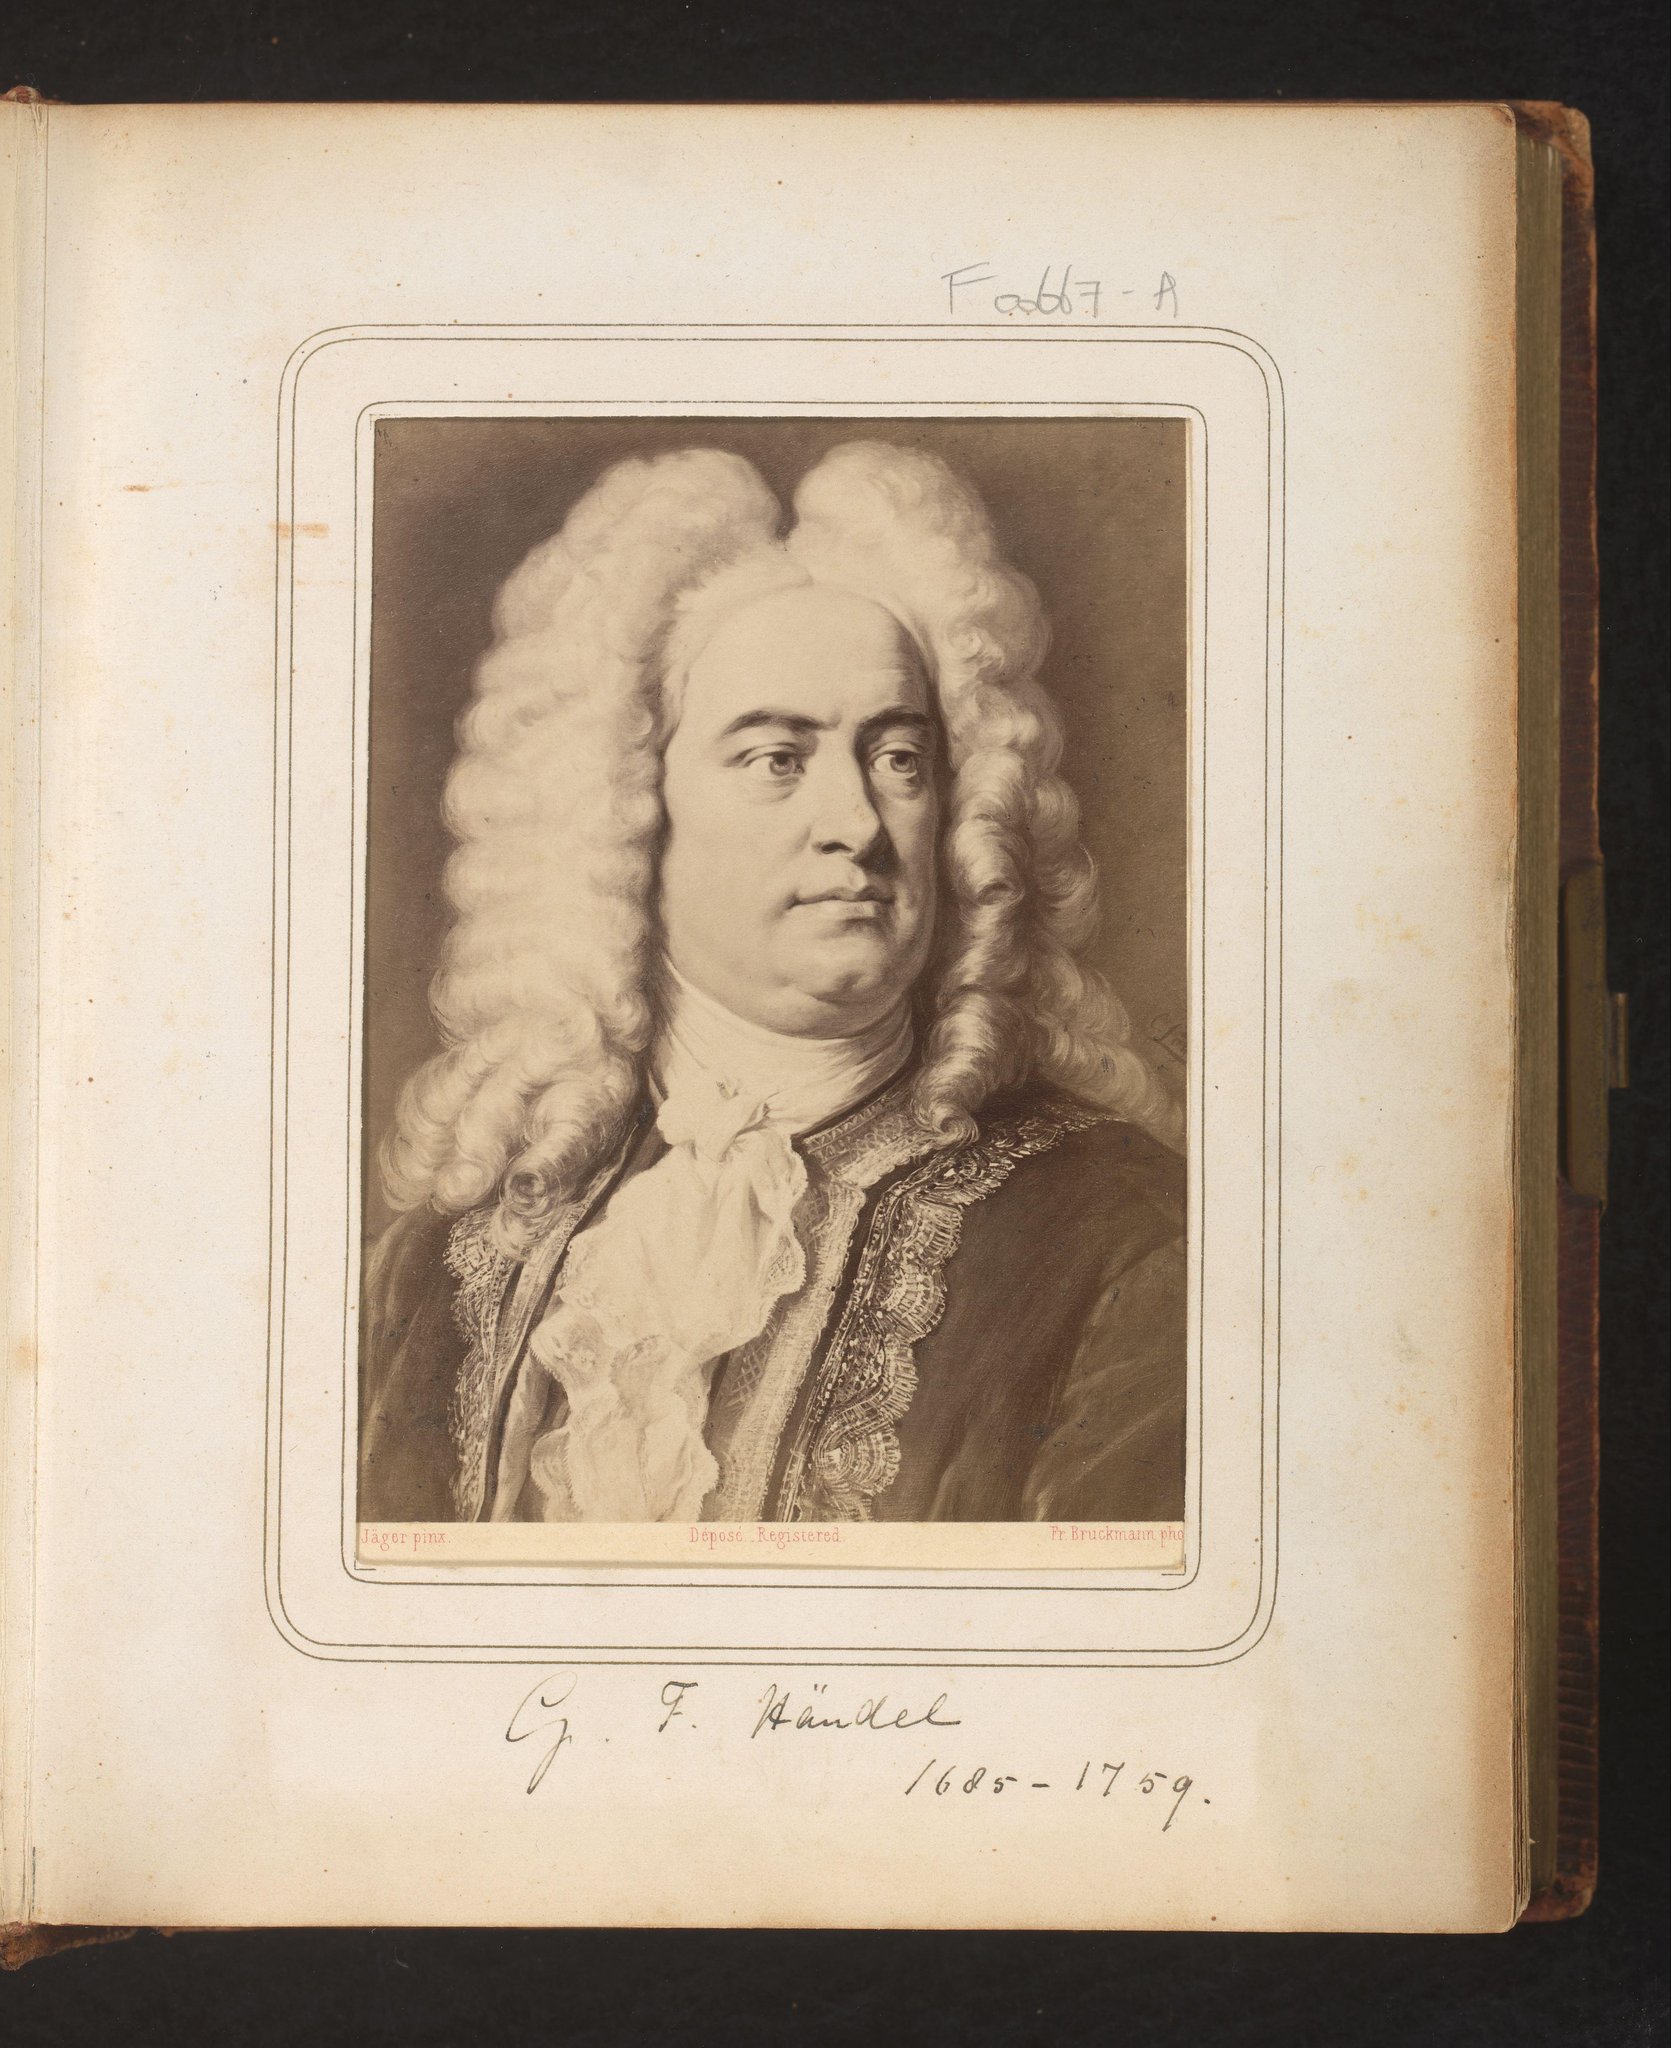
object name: reproduction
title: Fotoreproductie van een geschilderd portret van Georg Friedrich Handel door Carl Jaeger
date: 1870-1890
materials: cardboard, photographic support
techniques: albumen print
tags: london, historical persons, portrait of composer, picture, painting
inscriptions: annotation: ‘G. F. Händel/ 1685-1759’, name: ‘Jäger pinx. Déposé Registered. Fr. Bruckmann’